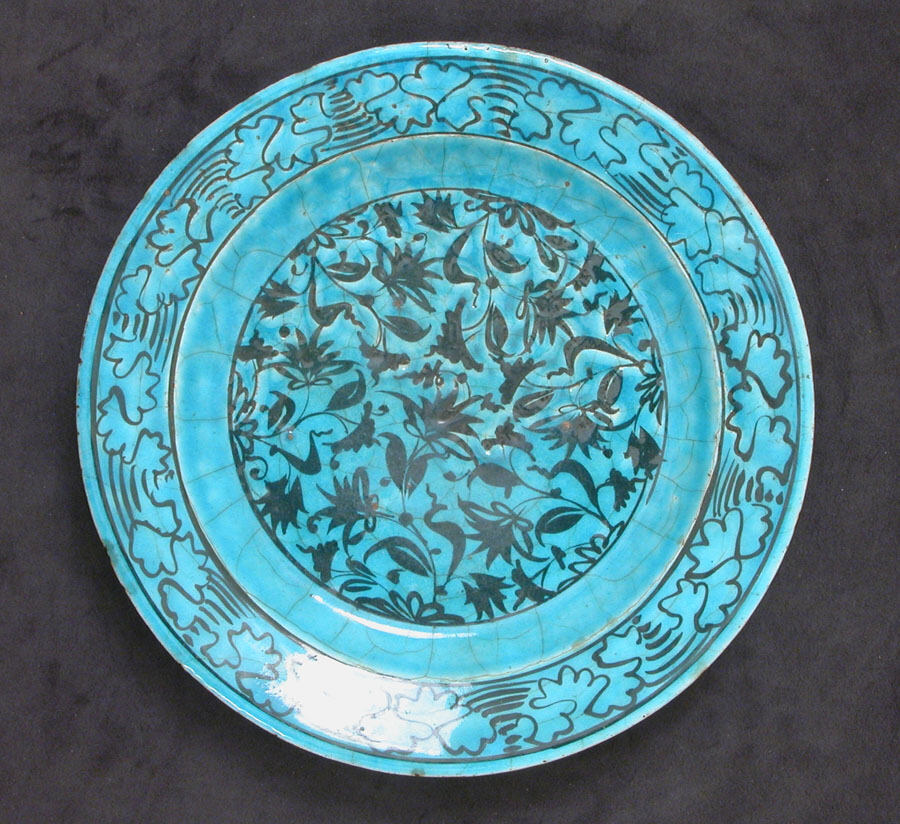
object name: dish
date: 1501-1700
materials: glaze, stonepaste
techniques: painting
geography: iran